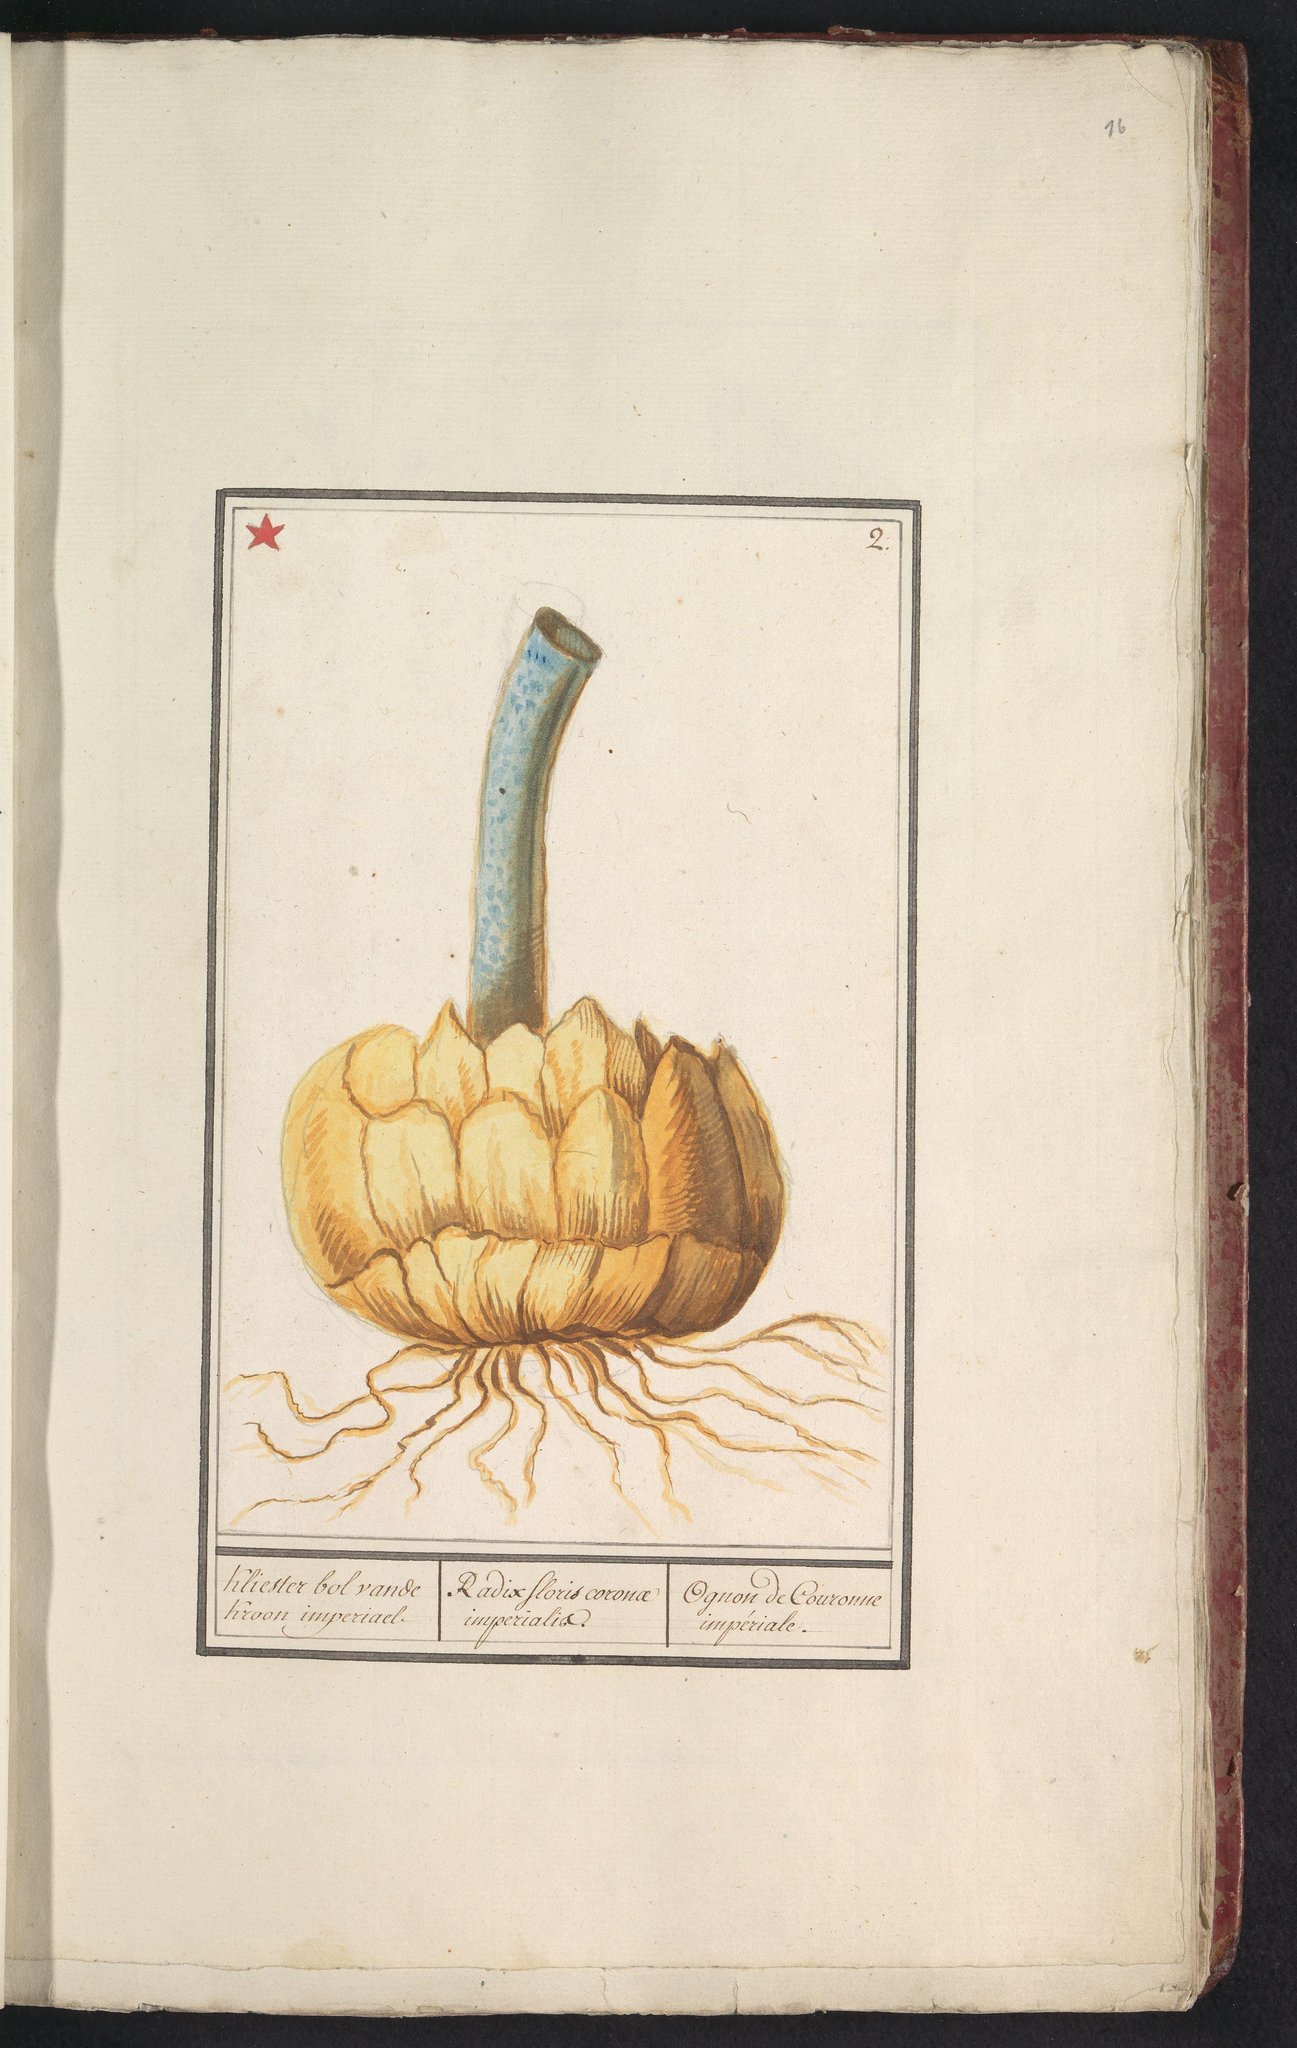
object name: drawing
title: Kliester bol van de Kroon imperiael. / Radix floris coronae imperialis / Ognon de Couronne impériale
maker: Anonymous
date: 1796-1814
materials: chalk, paint, paper, watercolor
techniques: brush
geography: southern netherlands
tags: flowers: crown imperial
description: Bol van de keizerskroon. Genummerd rechtsboven: 2. Linksboven gemerkt met een rood sterretje. Onderdeel van het eerste album met tekeningen van bloemen en planten. Achtste van twaalf albums met tekeningen van dieren, vogels en planten bekend rond 1600, gemaakt in opdracht van keizer Rudolf II. Met toelichting in Nederlands, Latijn en Frans.